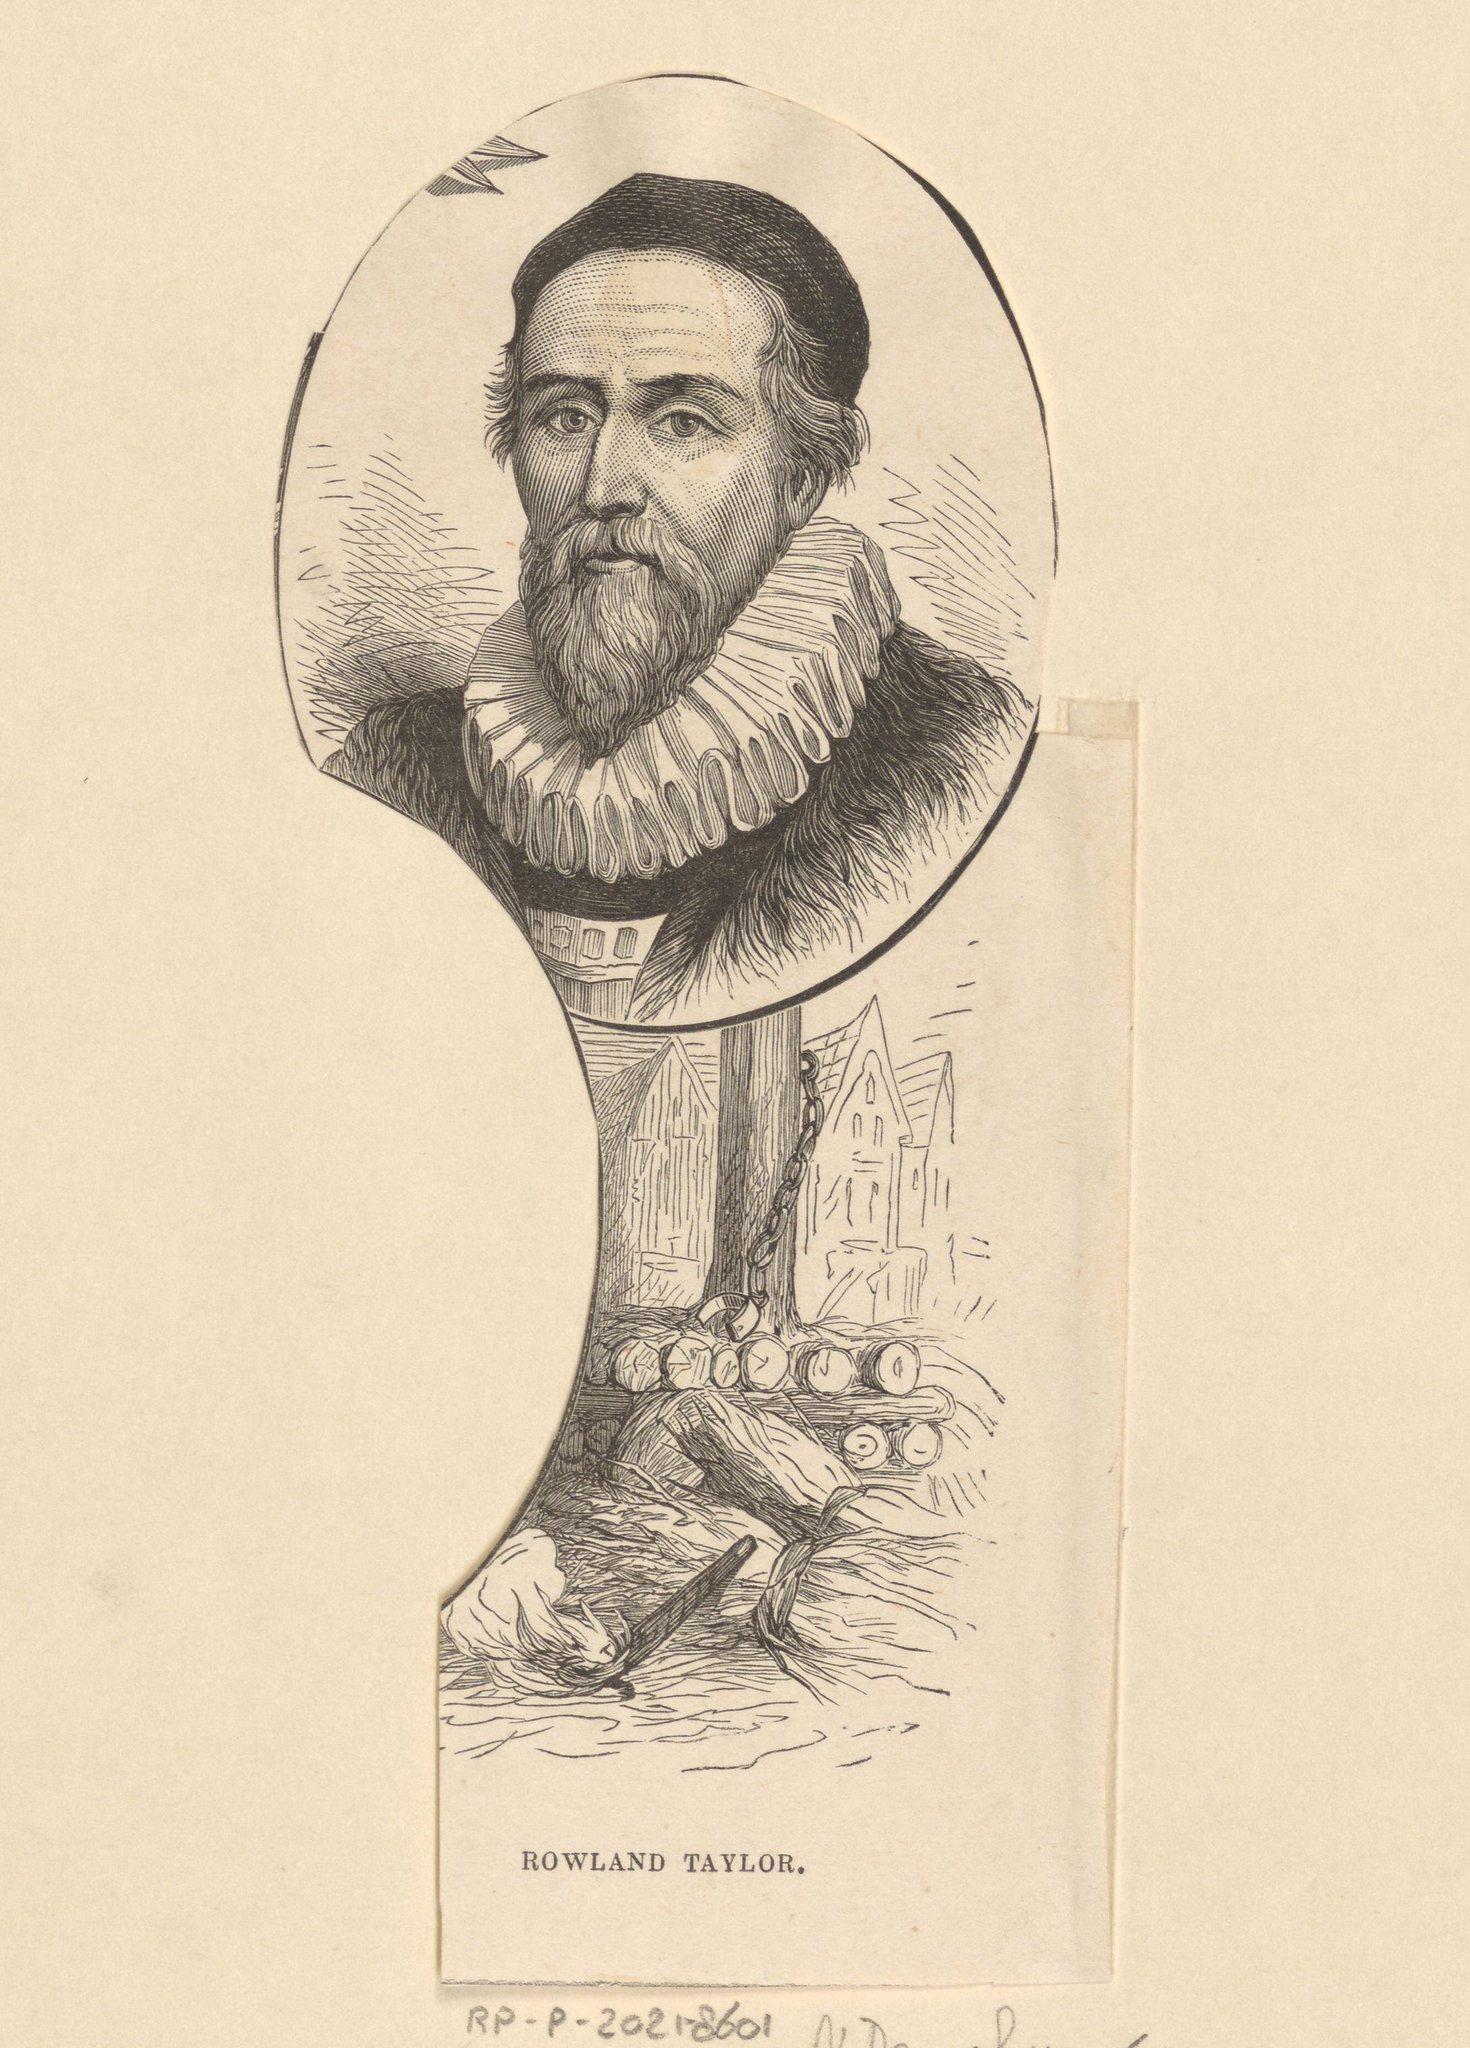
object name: print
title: Portret van Rowland Taylor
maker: Anonymous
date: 1850-1899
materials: paper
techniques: engraving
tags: historical persons